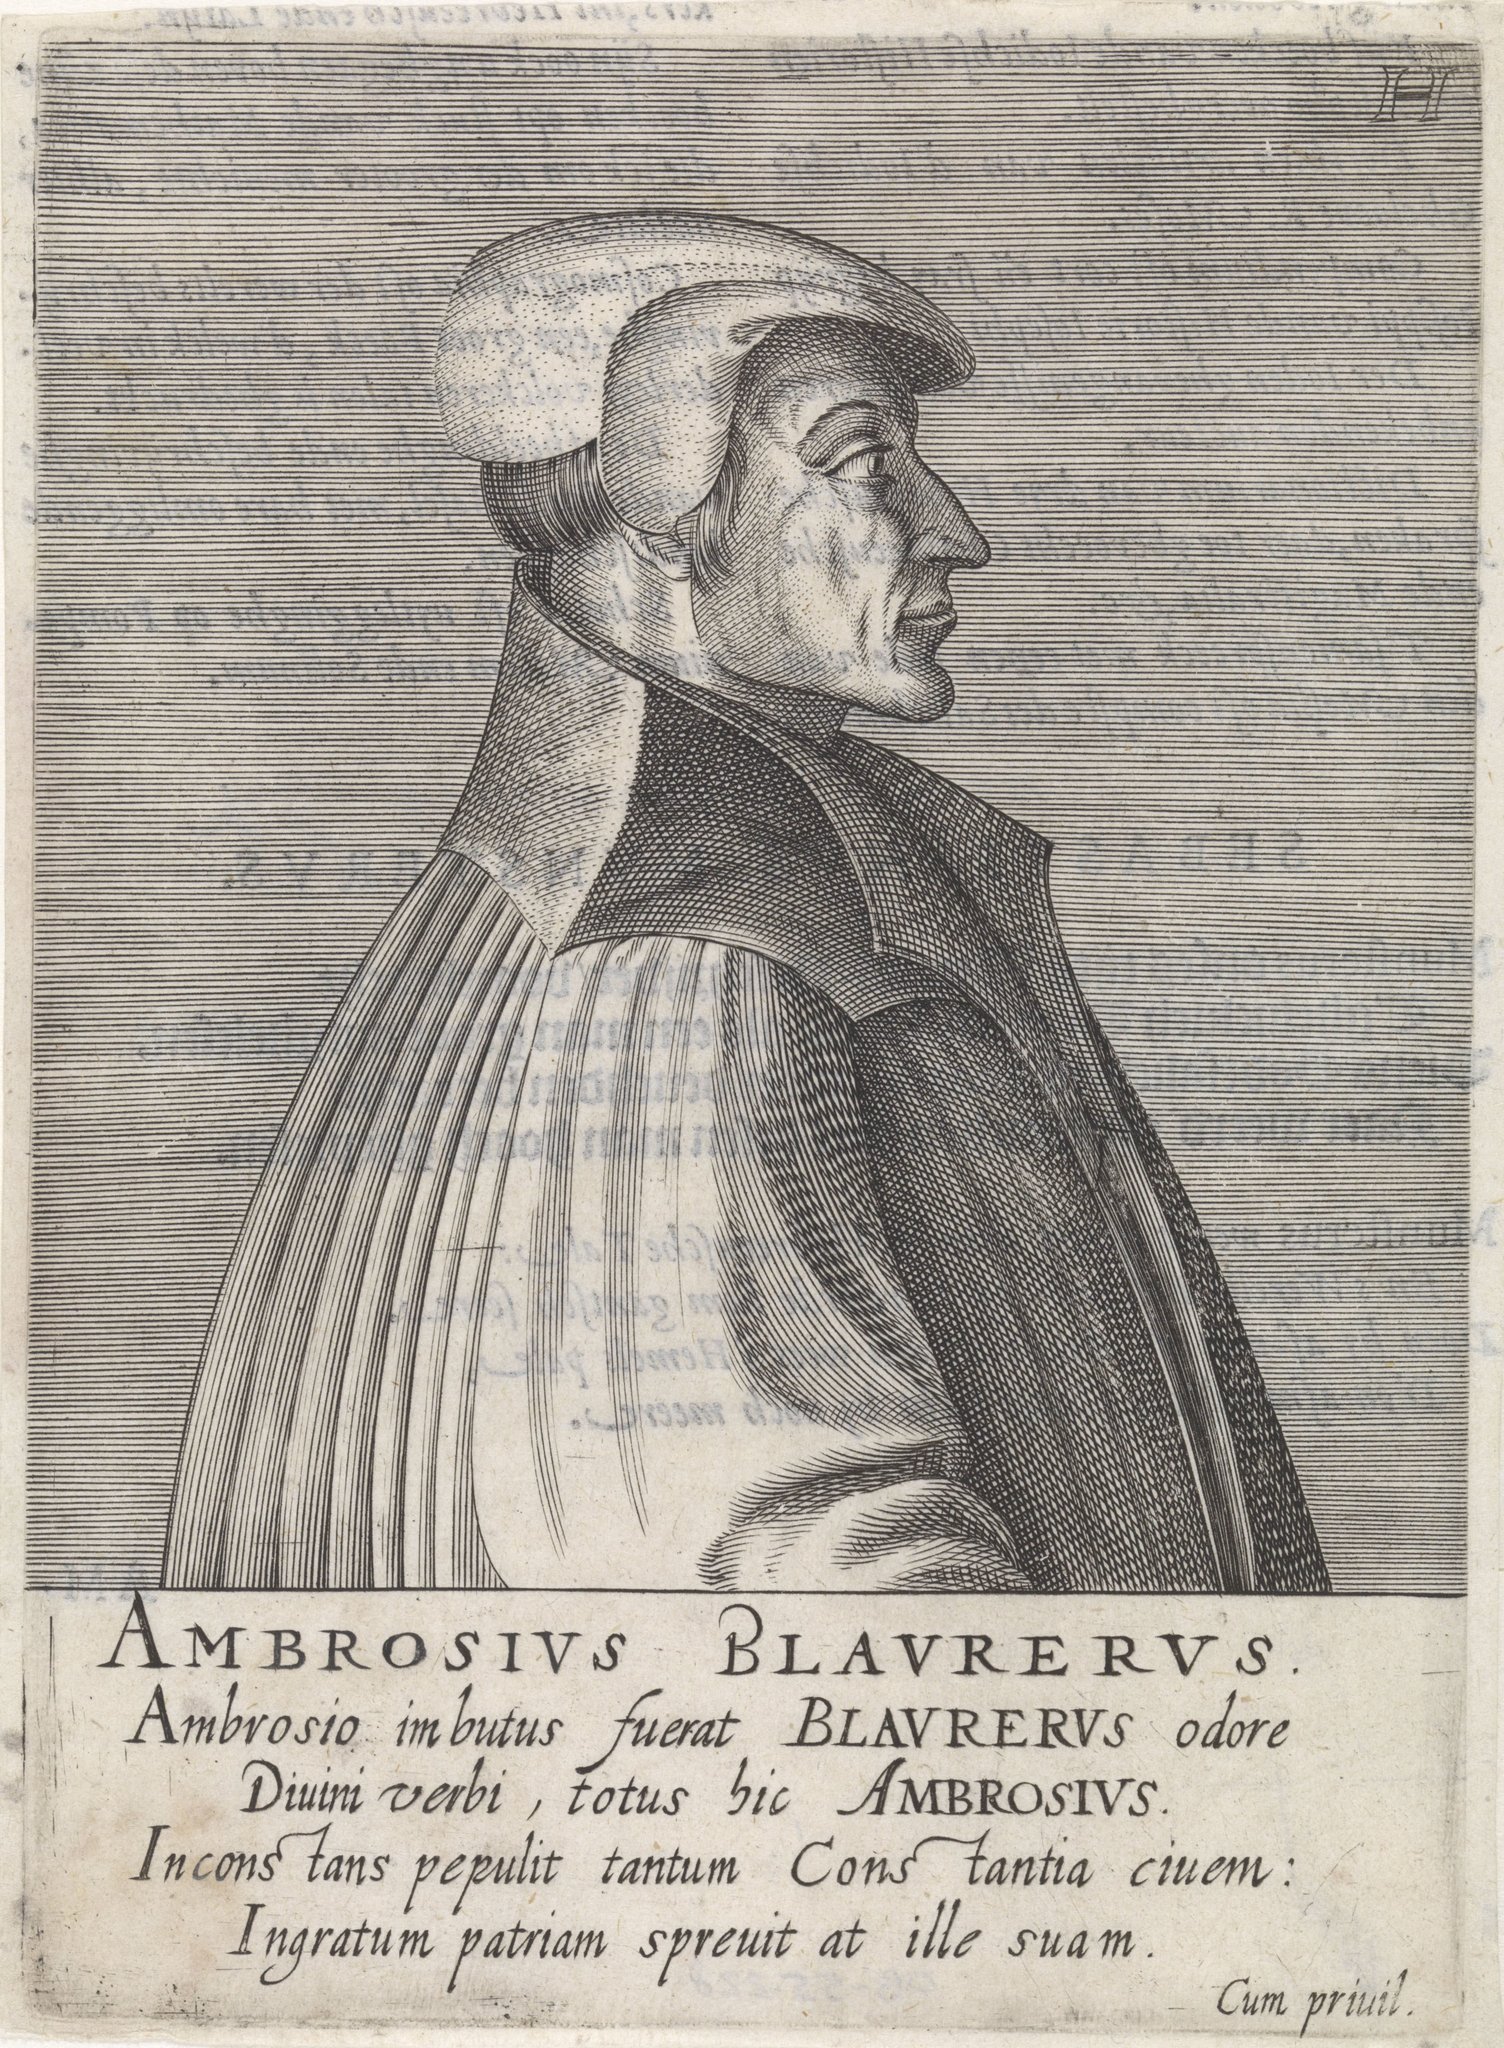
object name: print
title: Beroemde hervormers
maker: hendrick hondius (i)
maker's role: draughtsman, print maker, publisher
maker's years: 1573-1650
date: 1599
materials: paper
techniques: engraving, letterpress printing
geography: the hague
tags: ambrosius blaurer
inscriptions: collector's mark: Lugt 2228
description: Prent ook gebruikt als boekillustratie in: Jacob Verheiden, Præstantium aliquot theologorum, qui rom. antichristum præcipuè oppugnarunt, effigies. Den Haag: Hendrick Hondius I en Den Haag: B.C. Nieulandt, 1602-1603. Tevens: Arnhem, J.Janssen, 1604.